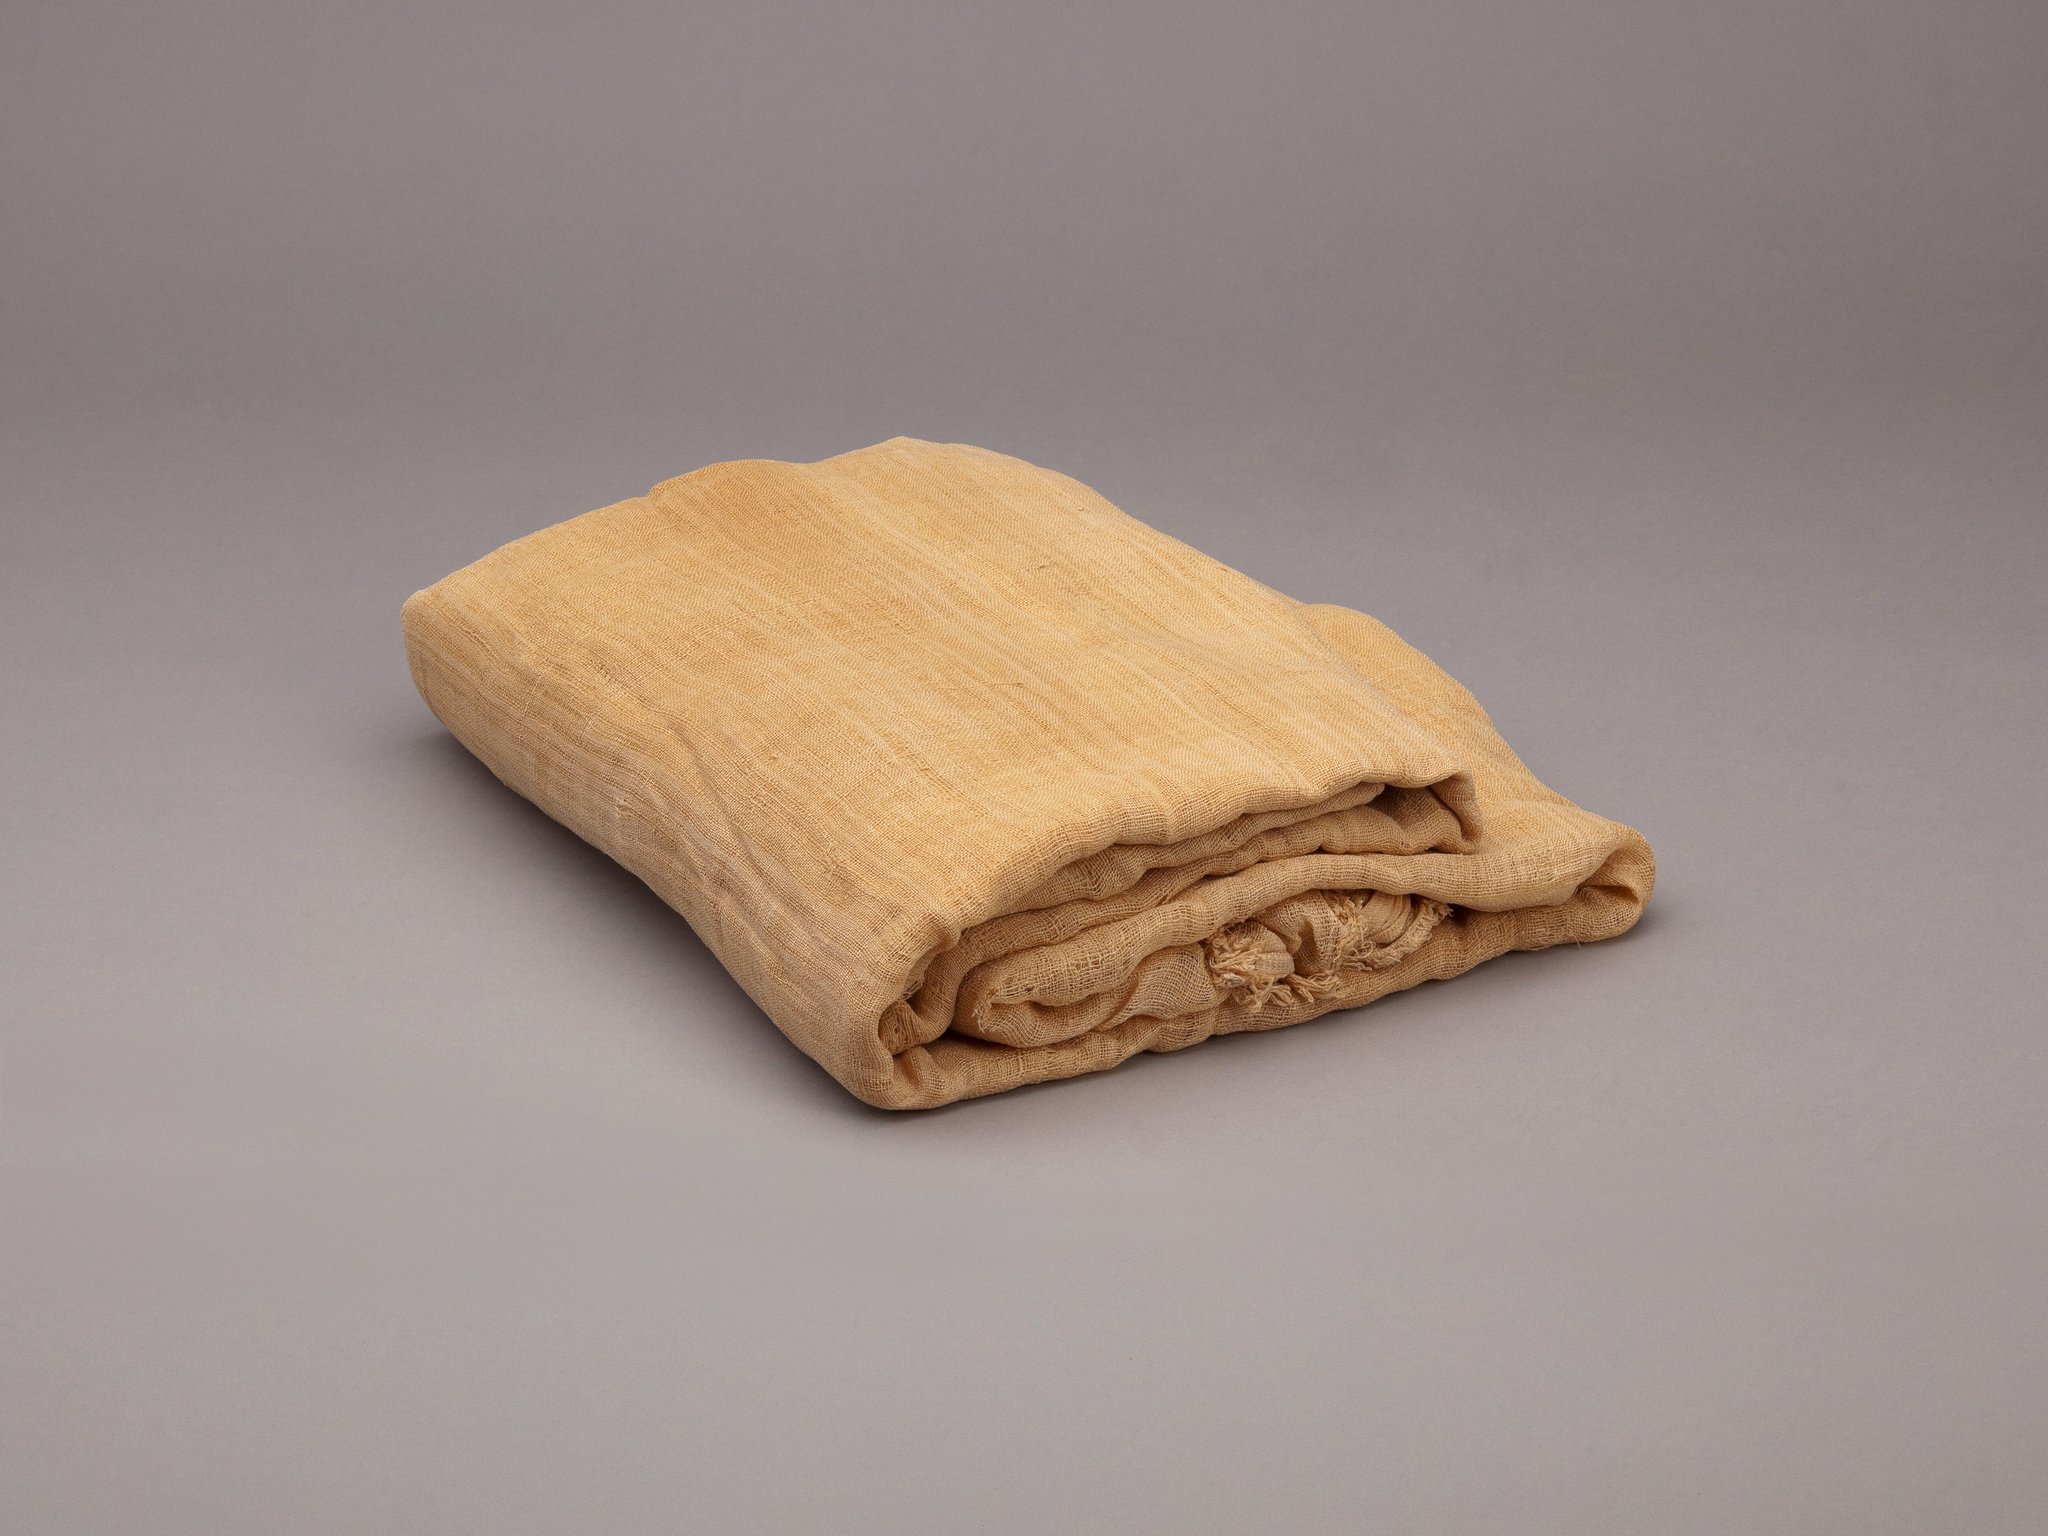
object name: linen mark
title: Sheet, linen mark, coarse spin, irregular weave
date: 1492-1473 BCE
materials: linen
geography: egypt